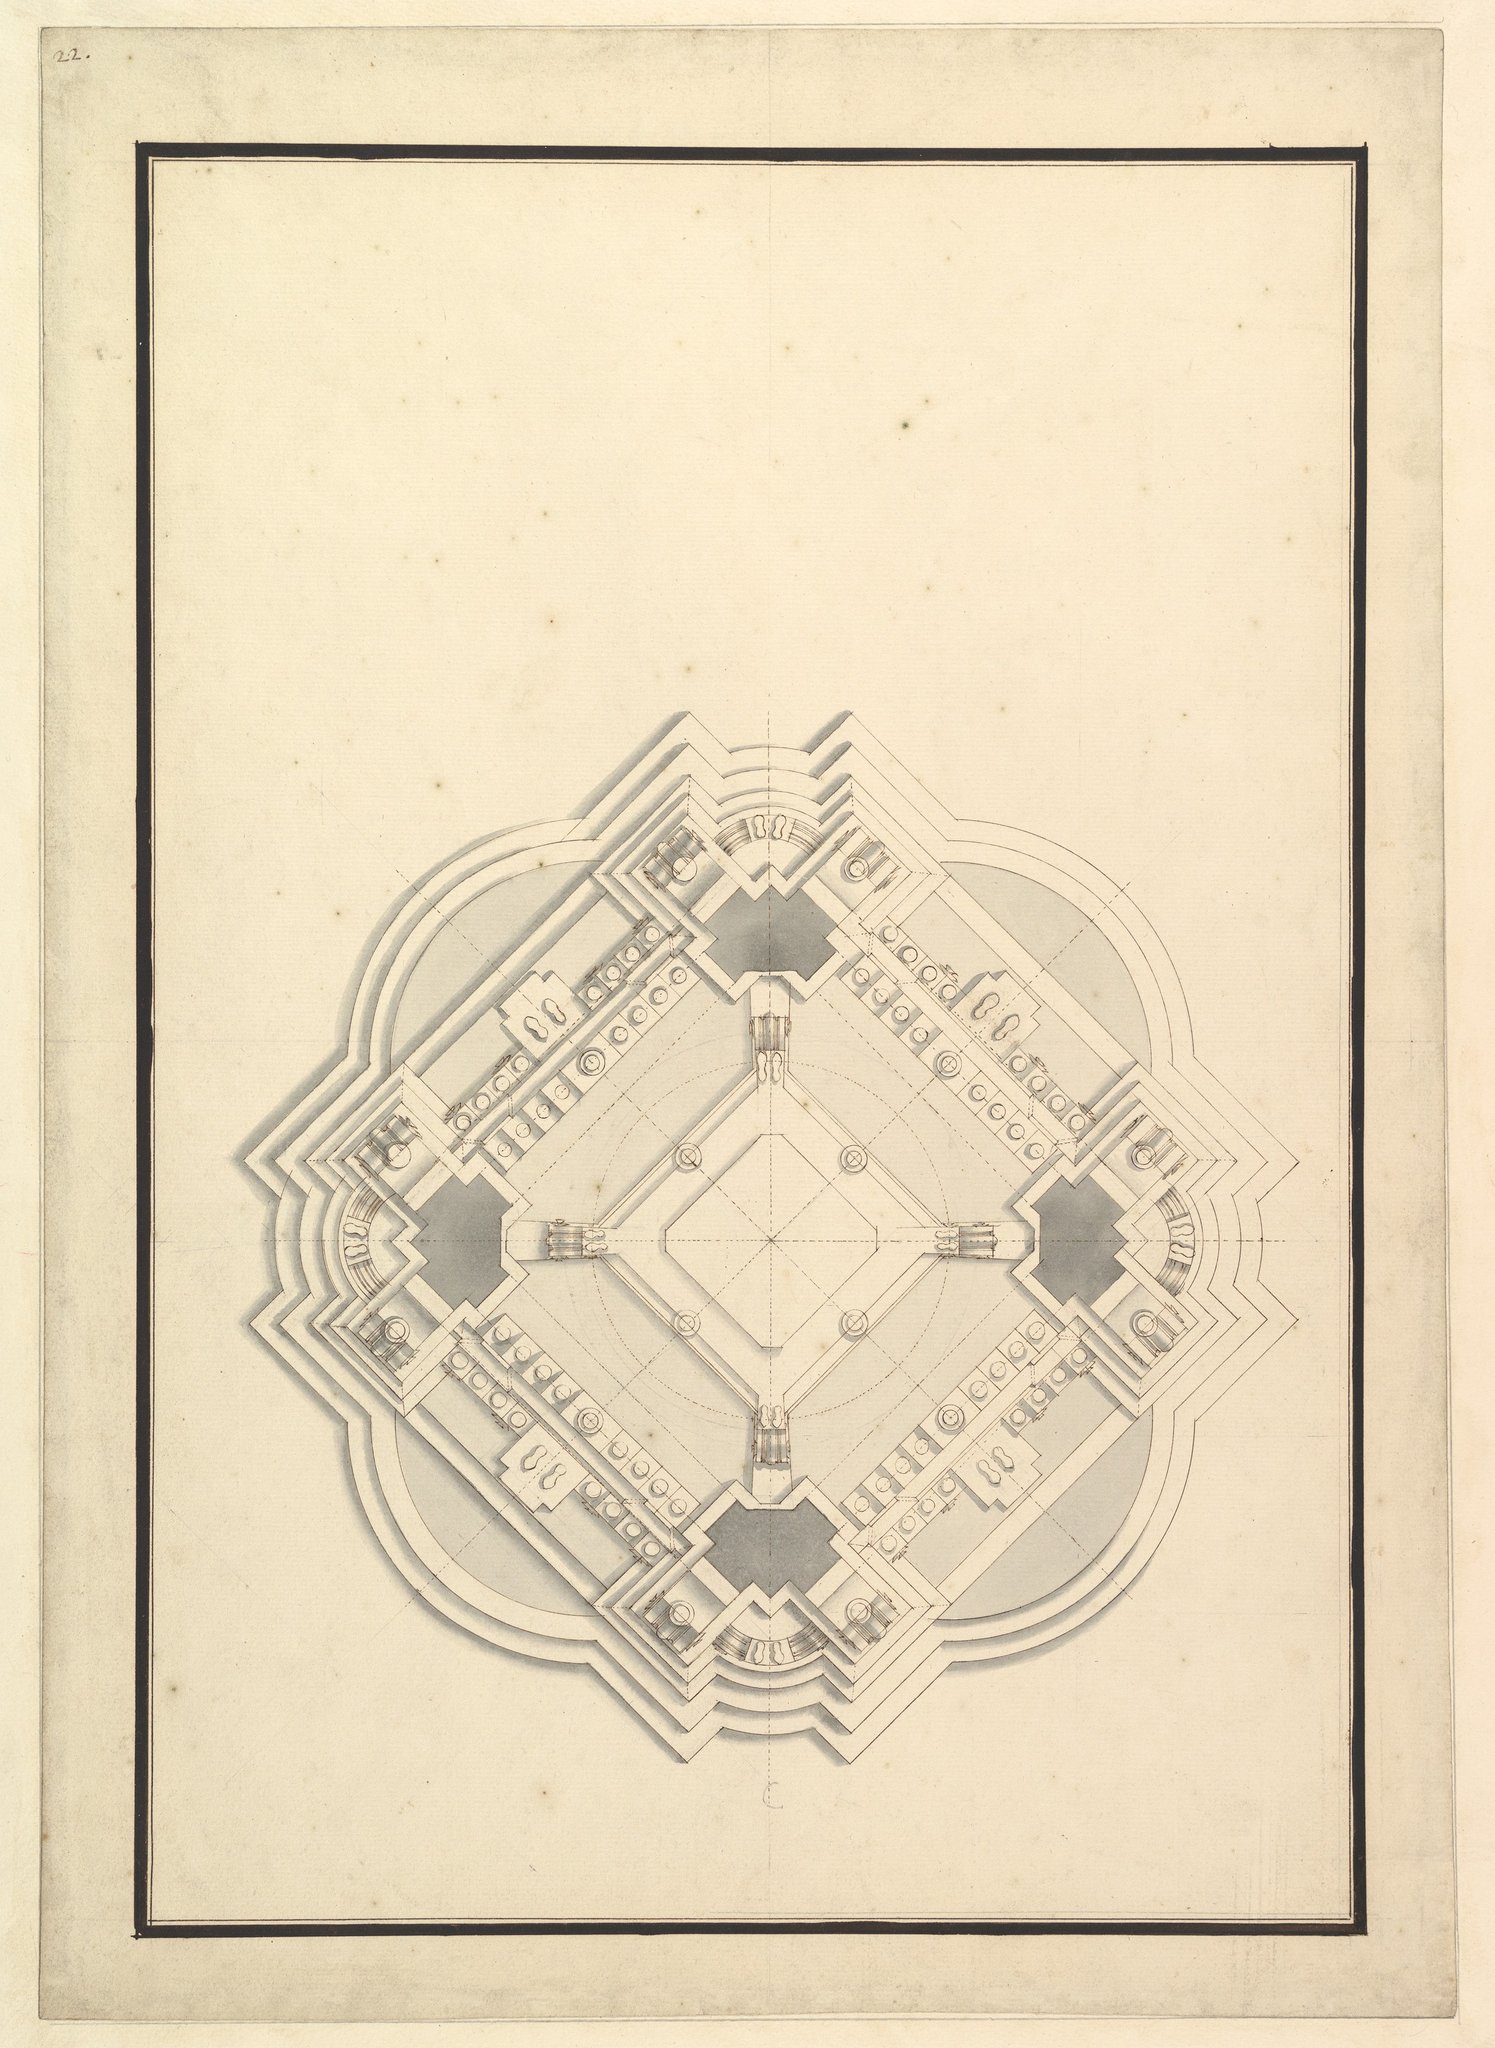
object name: drawing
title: Ground Plan for a Catafalque for Louis I, King of Spain (reigned only a few months, died 1724)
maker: giuseppe galli bibiena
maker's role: artist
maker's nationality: italian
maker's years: 1696-1756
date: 1724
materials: ink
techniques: pen, wash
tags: architecture